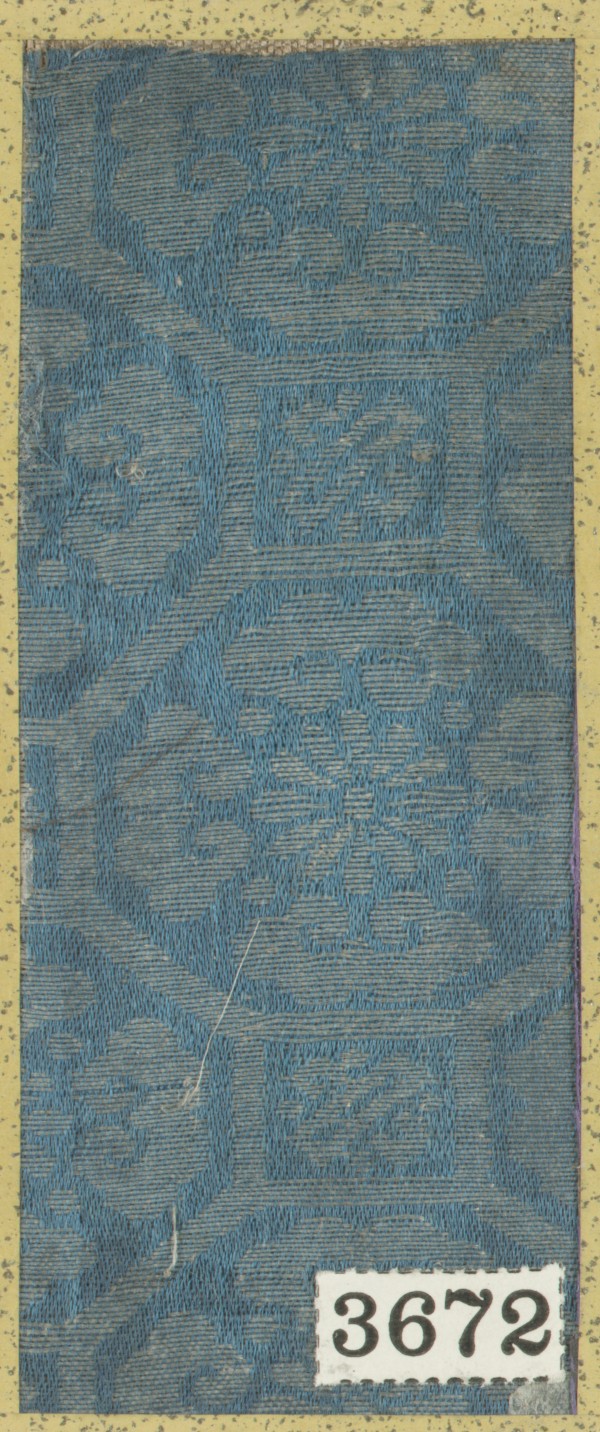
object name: sample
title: Textile Sample from Sample Book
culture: japanese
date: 1801-1900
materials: silk